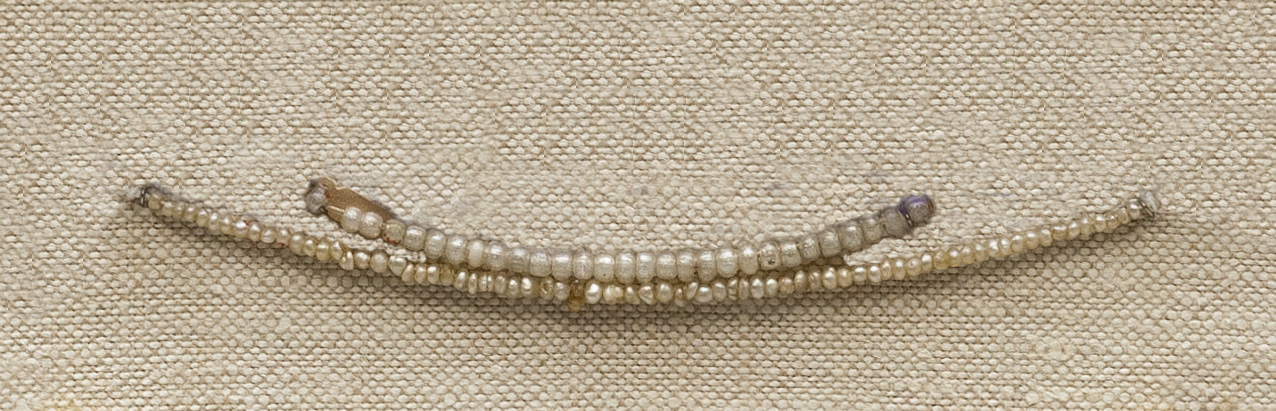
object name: bead, string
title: String of 29 Beads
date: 200 BCE-200 CE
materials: glass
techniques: silvered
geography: egypt